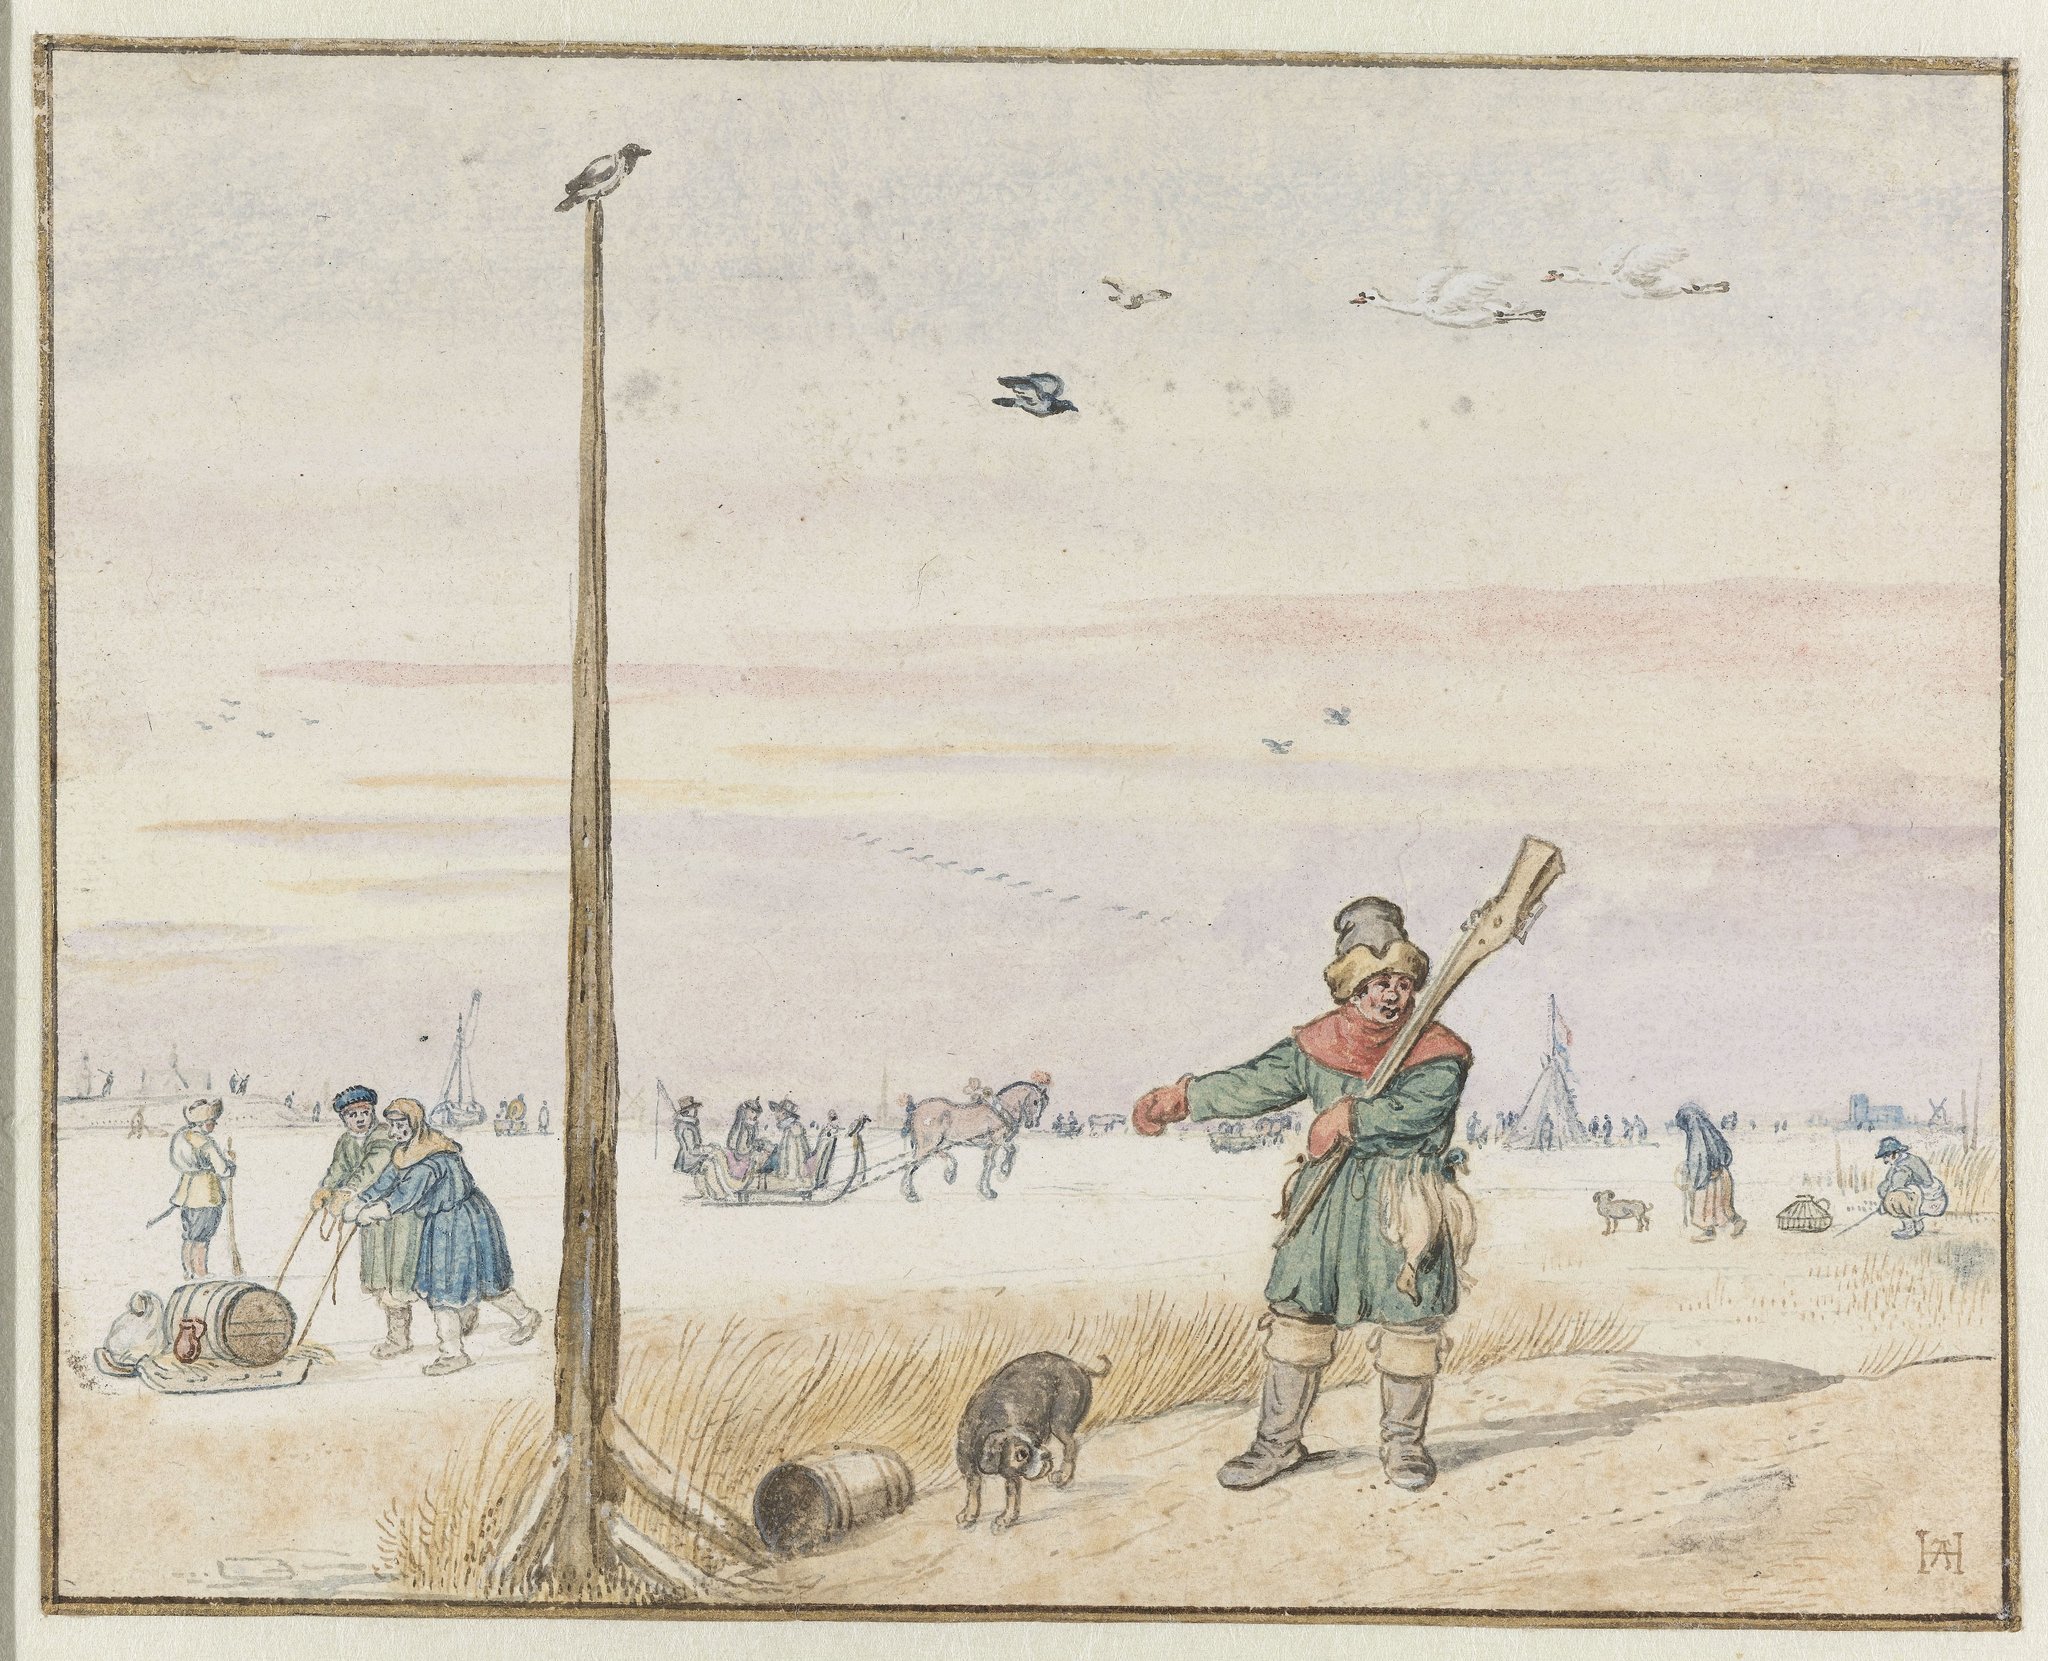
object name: drawing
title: Winter Landscape with a Duck Hunter with Game in his Belt and his Gun over his Shoulder on the Bank of a Frozen River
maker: hendrick avercamp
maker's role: draughtsman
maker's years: 1585-1634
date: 1625-1630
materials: paint, graphite, ink, paper, watercolor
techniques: brush, pen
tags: sleigh, sledge (non-sport), sledge, sleigh (winter sports), return from the hunt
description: Een eendenjager met zijn buit aan zijn gordel en zijn geweer over de schouder, aan de rand van een toegevroren rivier; op het ijs talrijke figuurtjes.